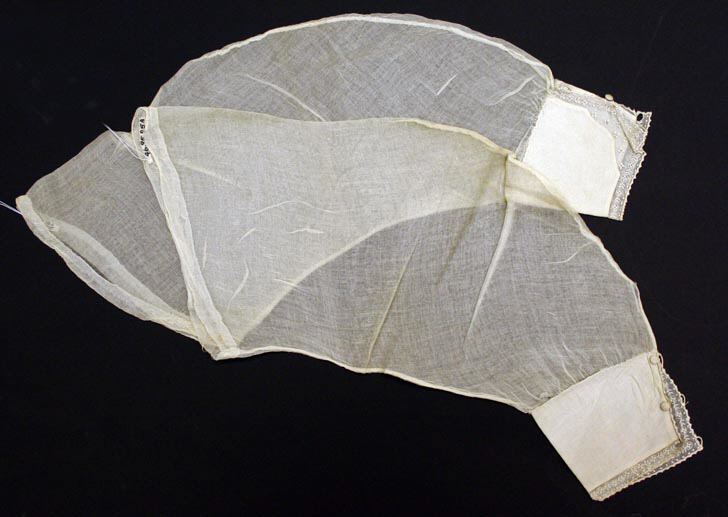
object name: sleeve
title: Sleeves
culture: american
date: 1850-1879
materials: linen